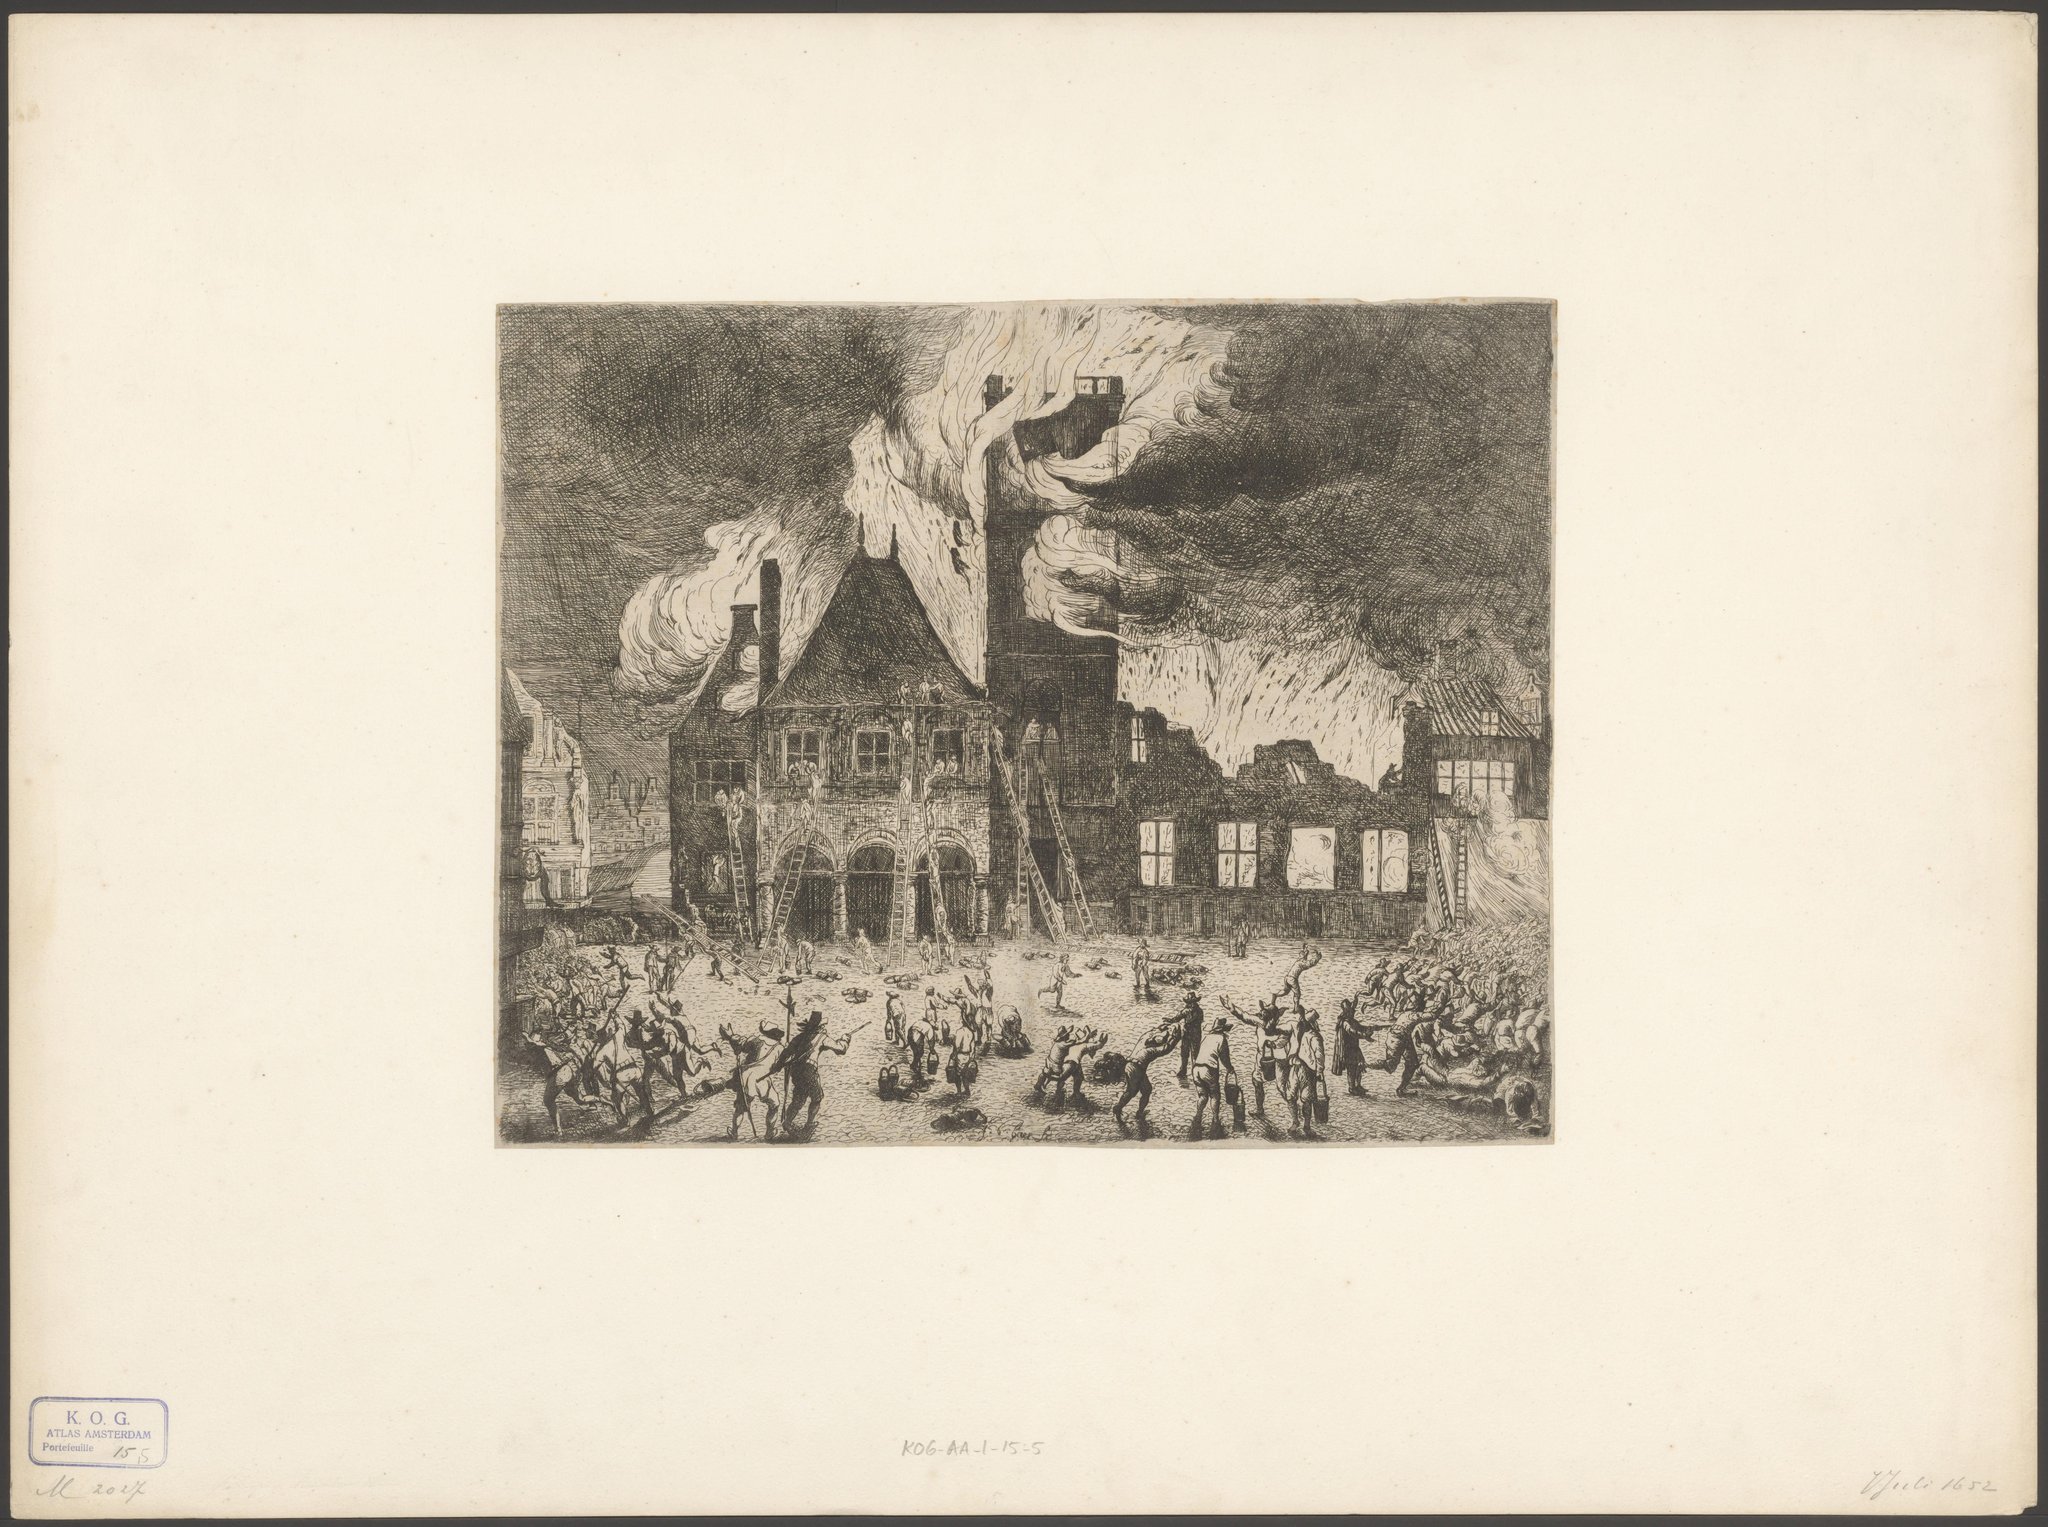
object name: print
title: Gezicht op de brand van in het oude stadhuis van Amsterdam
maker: Anonymous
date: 1652-1699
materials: paper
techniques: drypoint, etching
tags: on fire, ablaze, city-view in general; 'veduta', townhall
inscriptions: signature: ‘[...]aer’, collector's mark: ‘15,5’ Lugt 1641b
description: Onderwerpsrubriek binnen de Atlas Amsterdam: Brand & Ruïne Oude Stadhuis o/d Dam: e: Brand van het Stadhuis te Amsterdam.